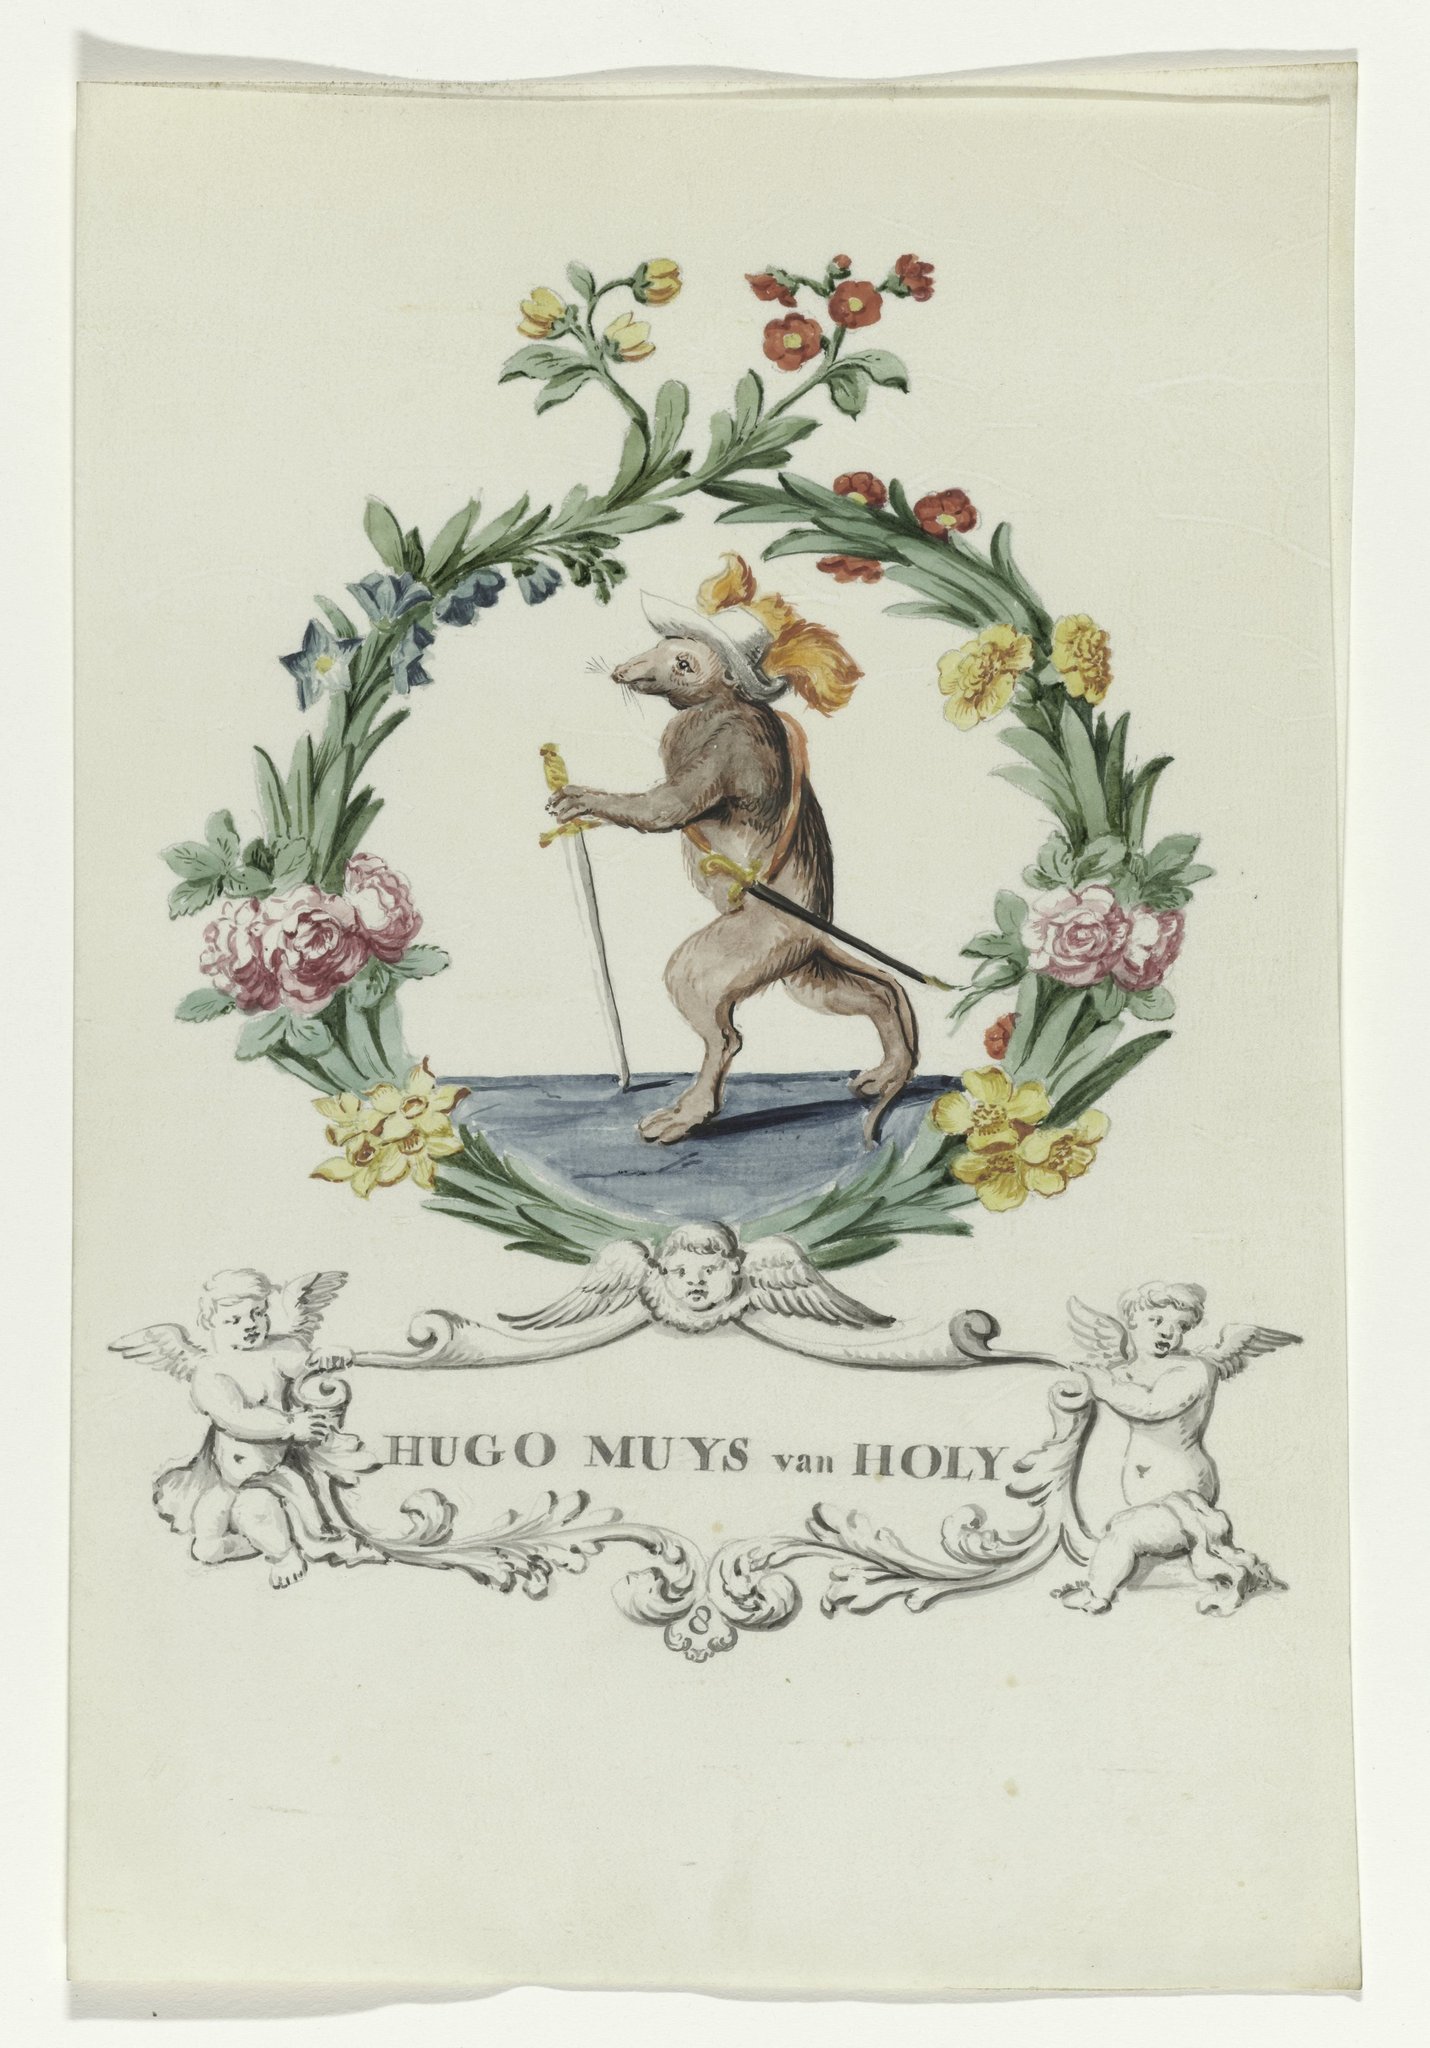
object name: drawing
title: Regtspleging van Oldenbarnevelt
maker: Anonymous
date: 1710-1720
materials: ink, parchment, watercolor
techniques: brush, pen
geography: netherlands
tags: johan van oldenbarnevelt, rodents: mouse, caricatures (human types), bad, corrupt judge, political caricatures and satires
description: Spotprent van Hugo Muys van Holy, rechter van Van Oldenbarnevelt; muis met 2 zwaarden en witte hoed met oranje pluim in krans van bloemen en bladeren. Daaronder cartouche met aan weerszijden en boven putti. In cartouche naam en daaronder nr. 8. Behorende bij serie aquarellen in boek.